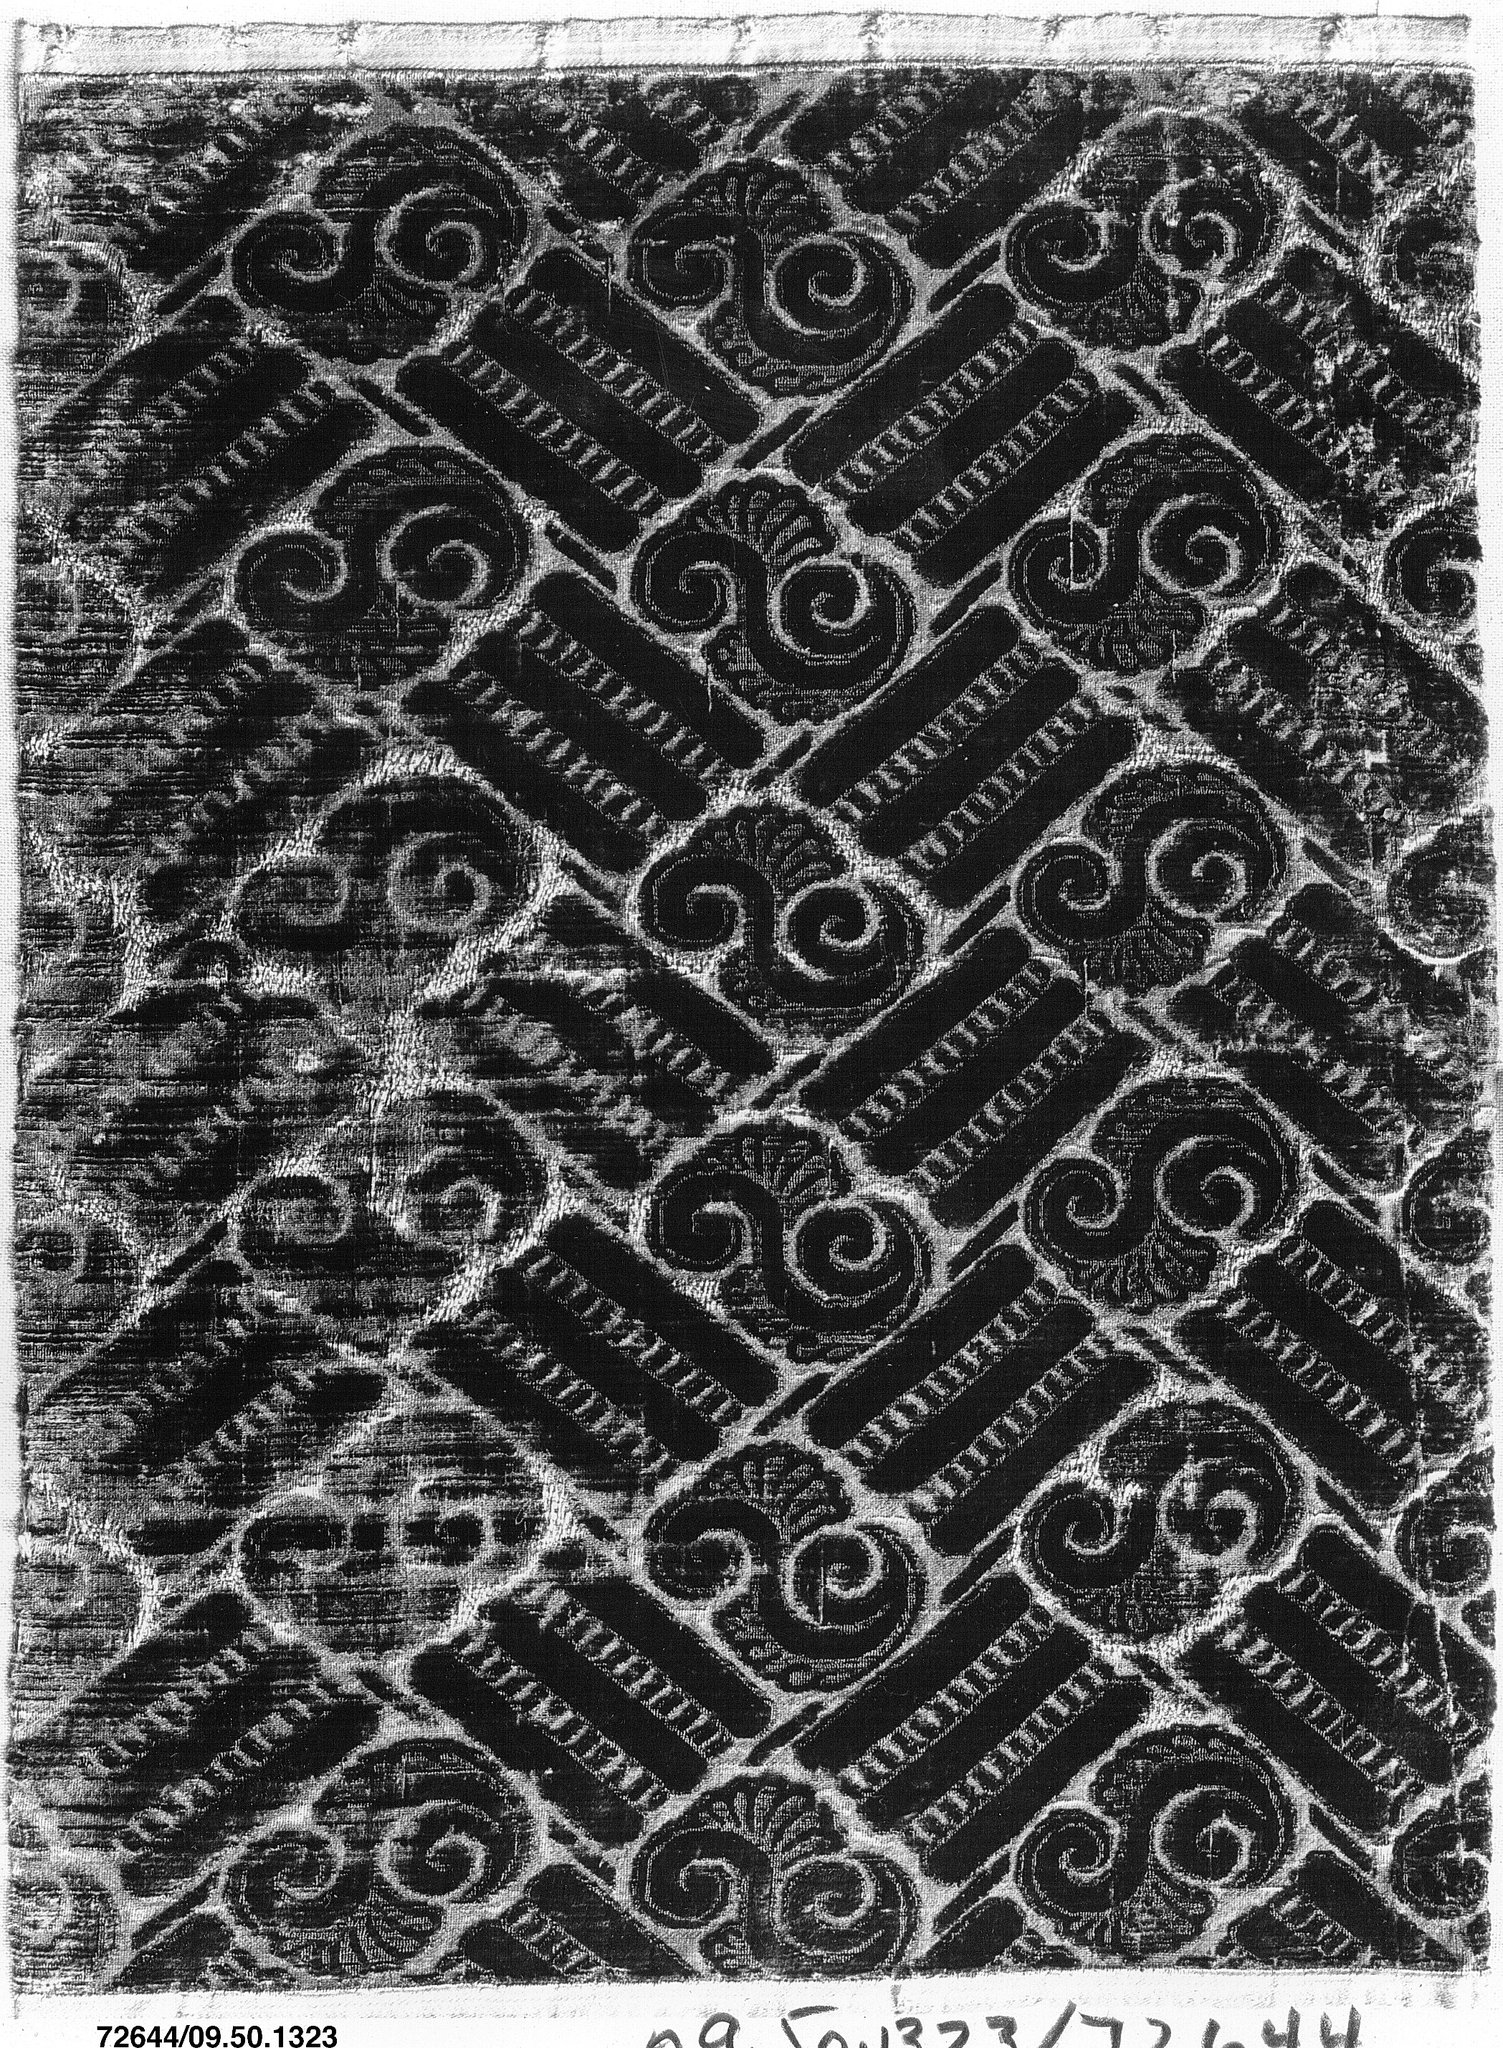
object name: piece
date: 1601-1700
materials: silk